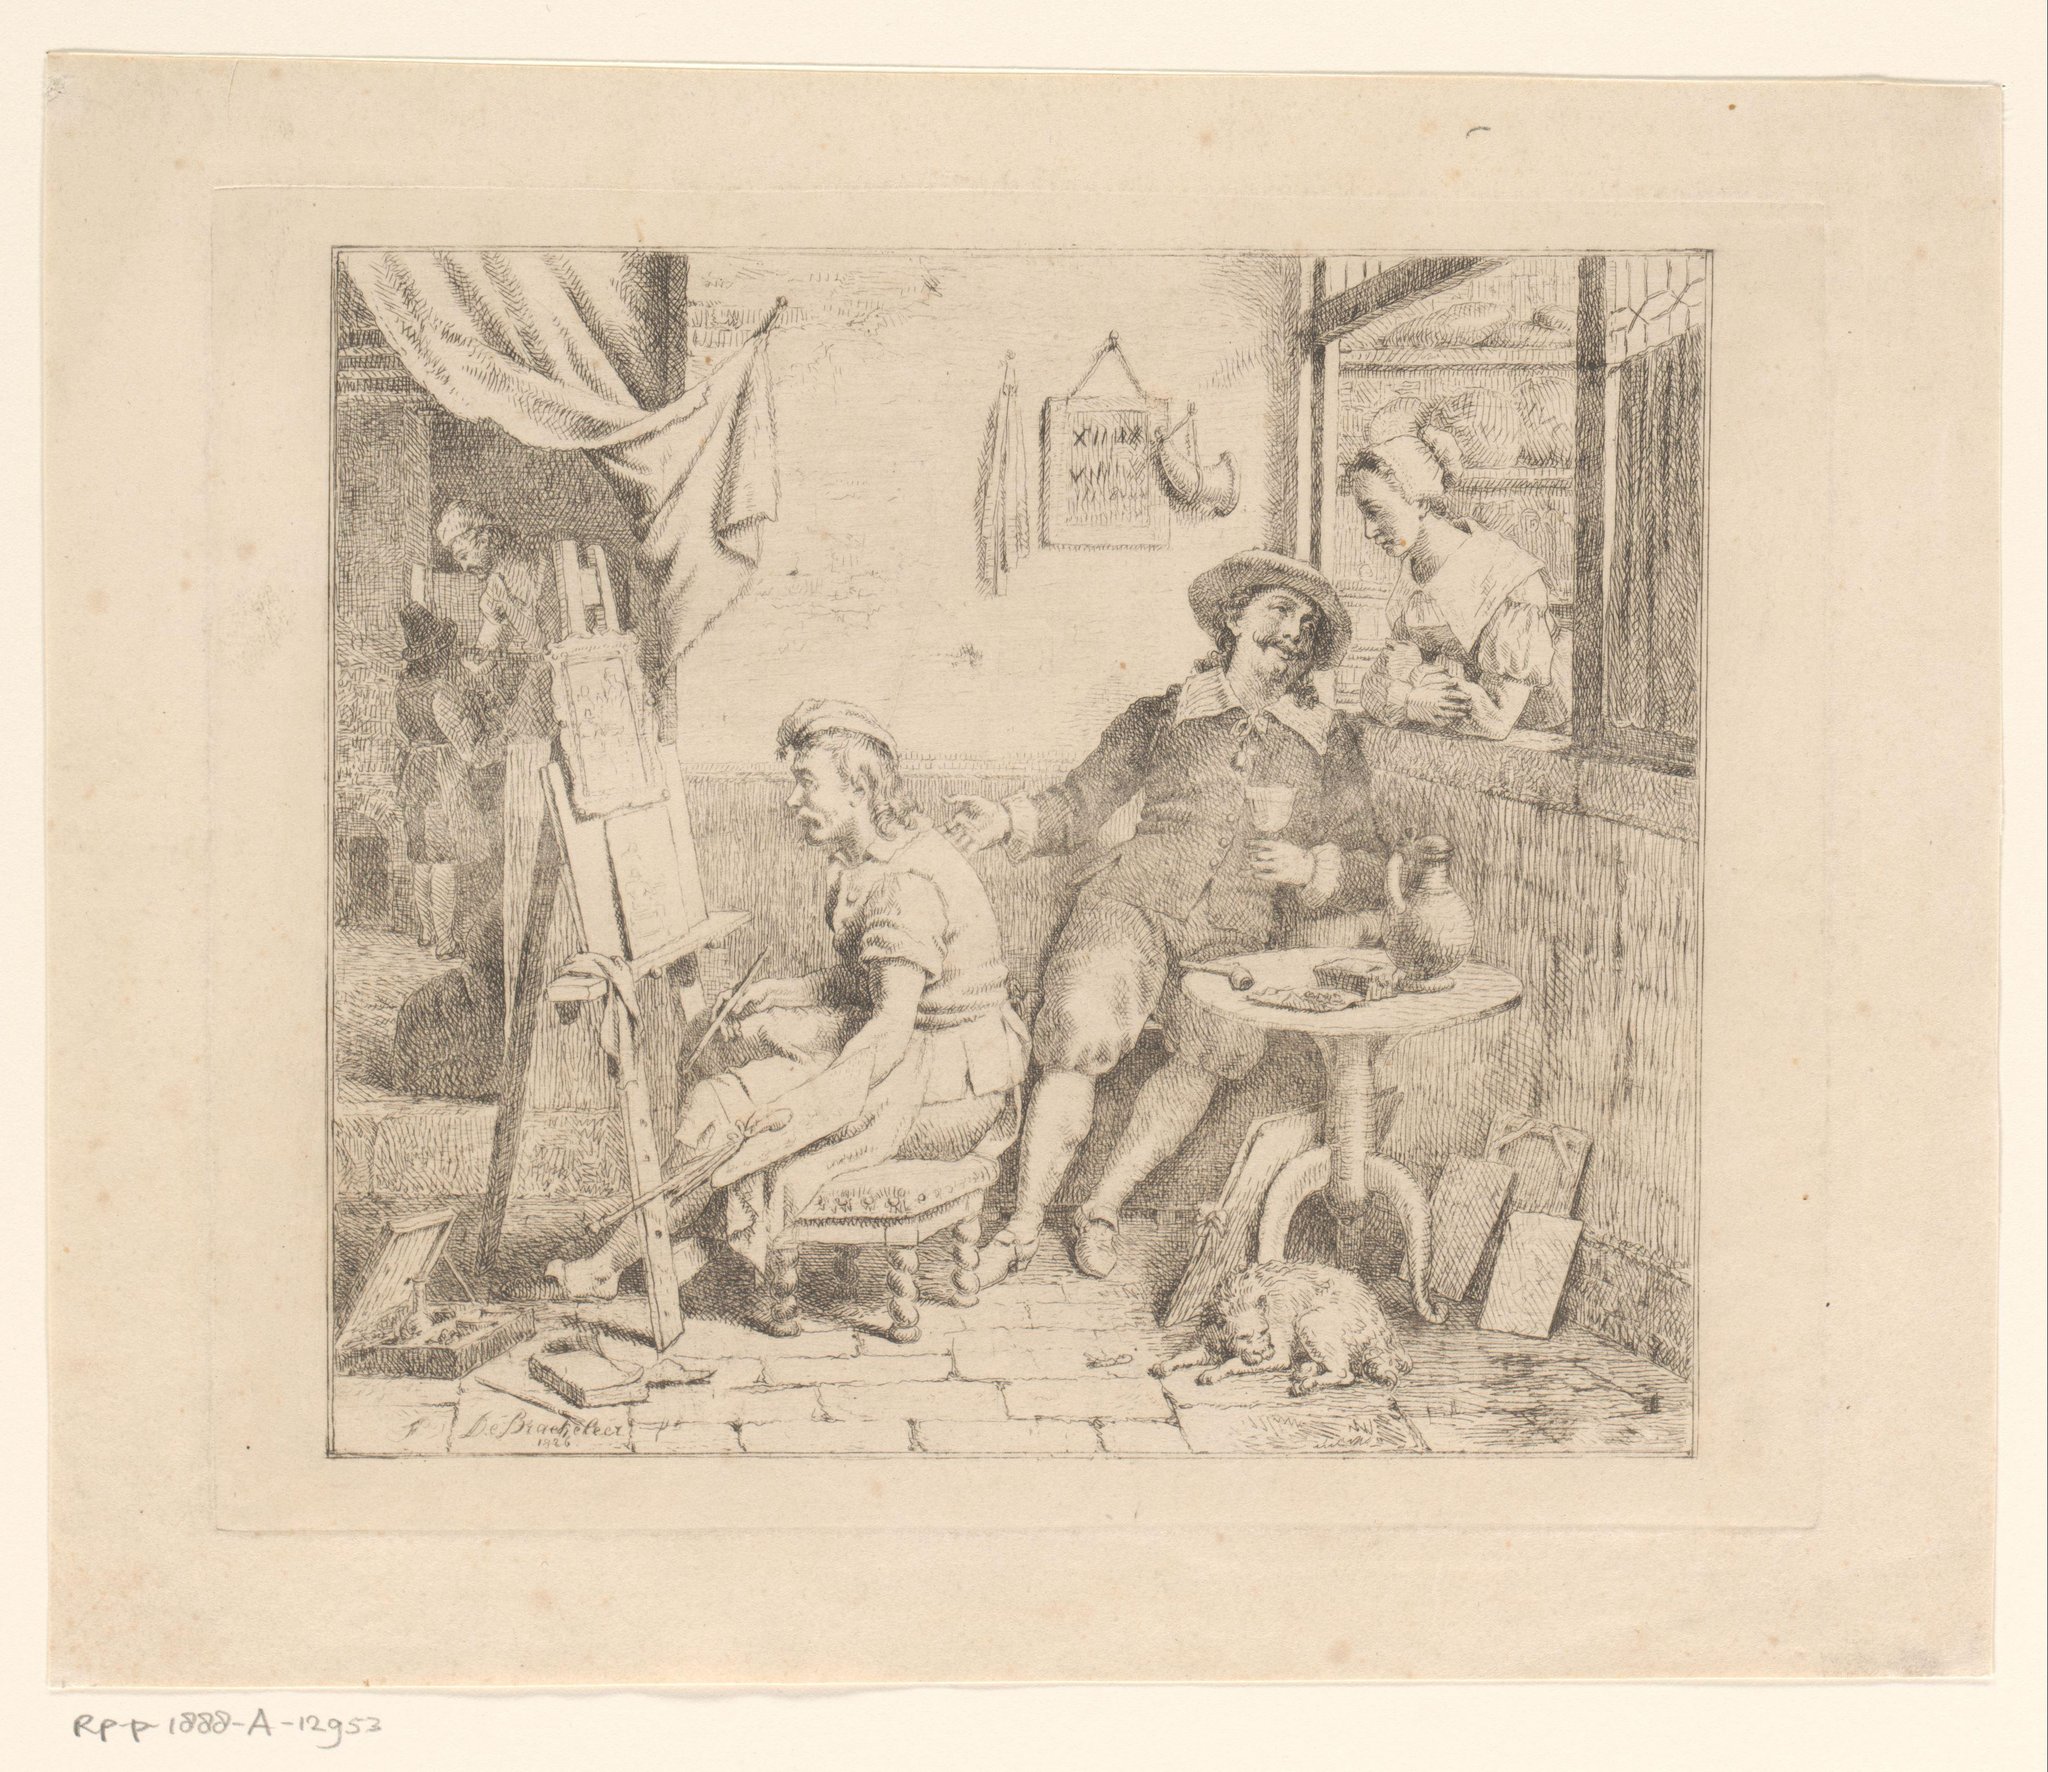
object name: print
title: Craesbeeck dans l'atelier de Brouwer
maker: ferdinand de braekeleer (i)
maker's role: draughtsman, print maker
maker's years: 1792-1883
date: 1826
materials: paper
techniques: etching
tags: painter at work, in his studio, drinking, patron (or client) visiting the artist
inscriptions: collector's mark: Lugt 2228